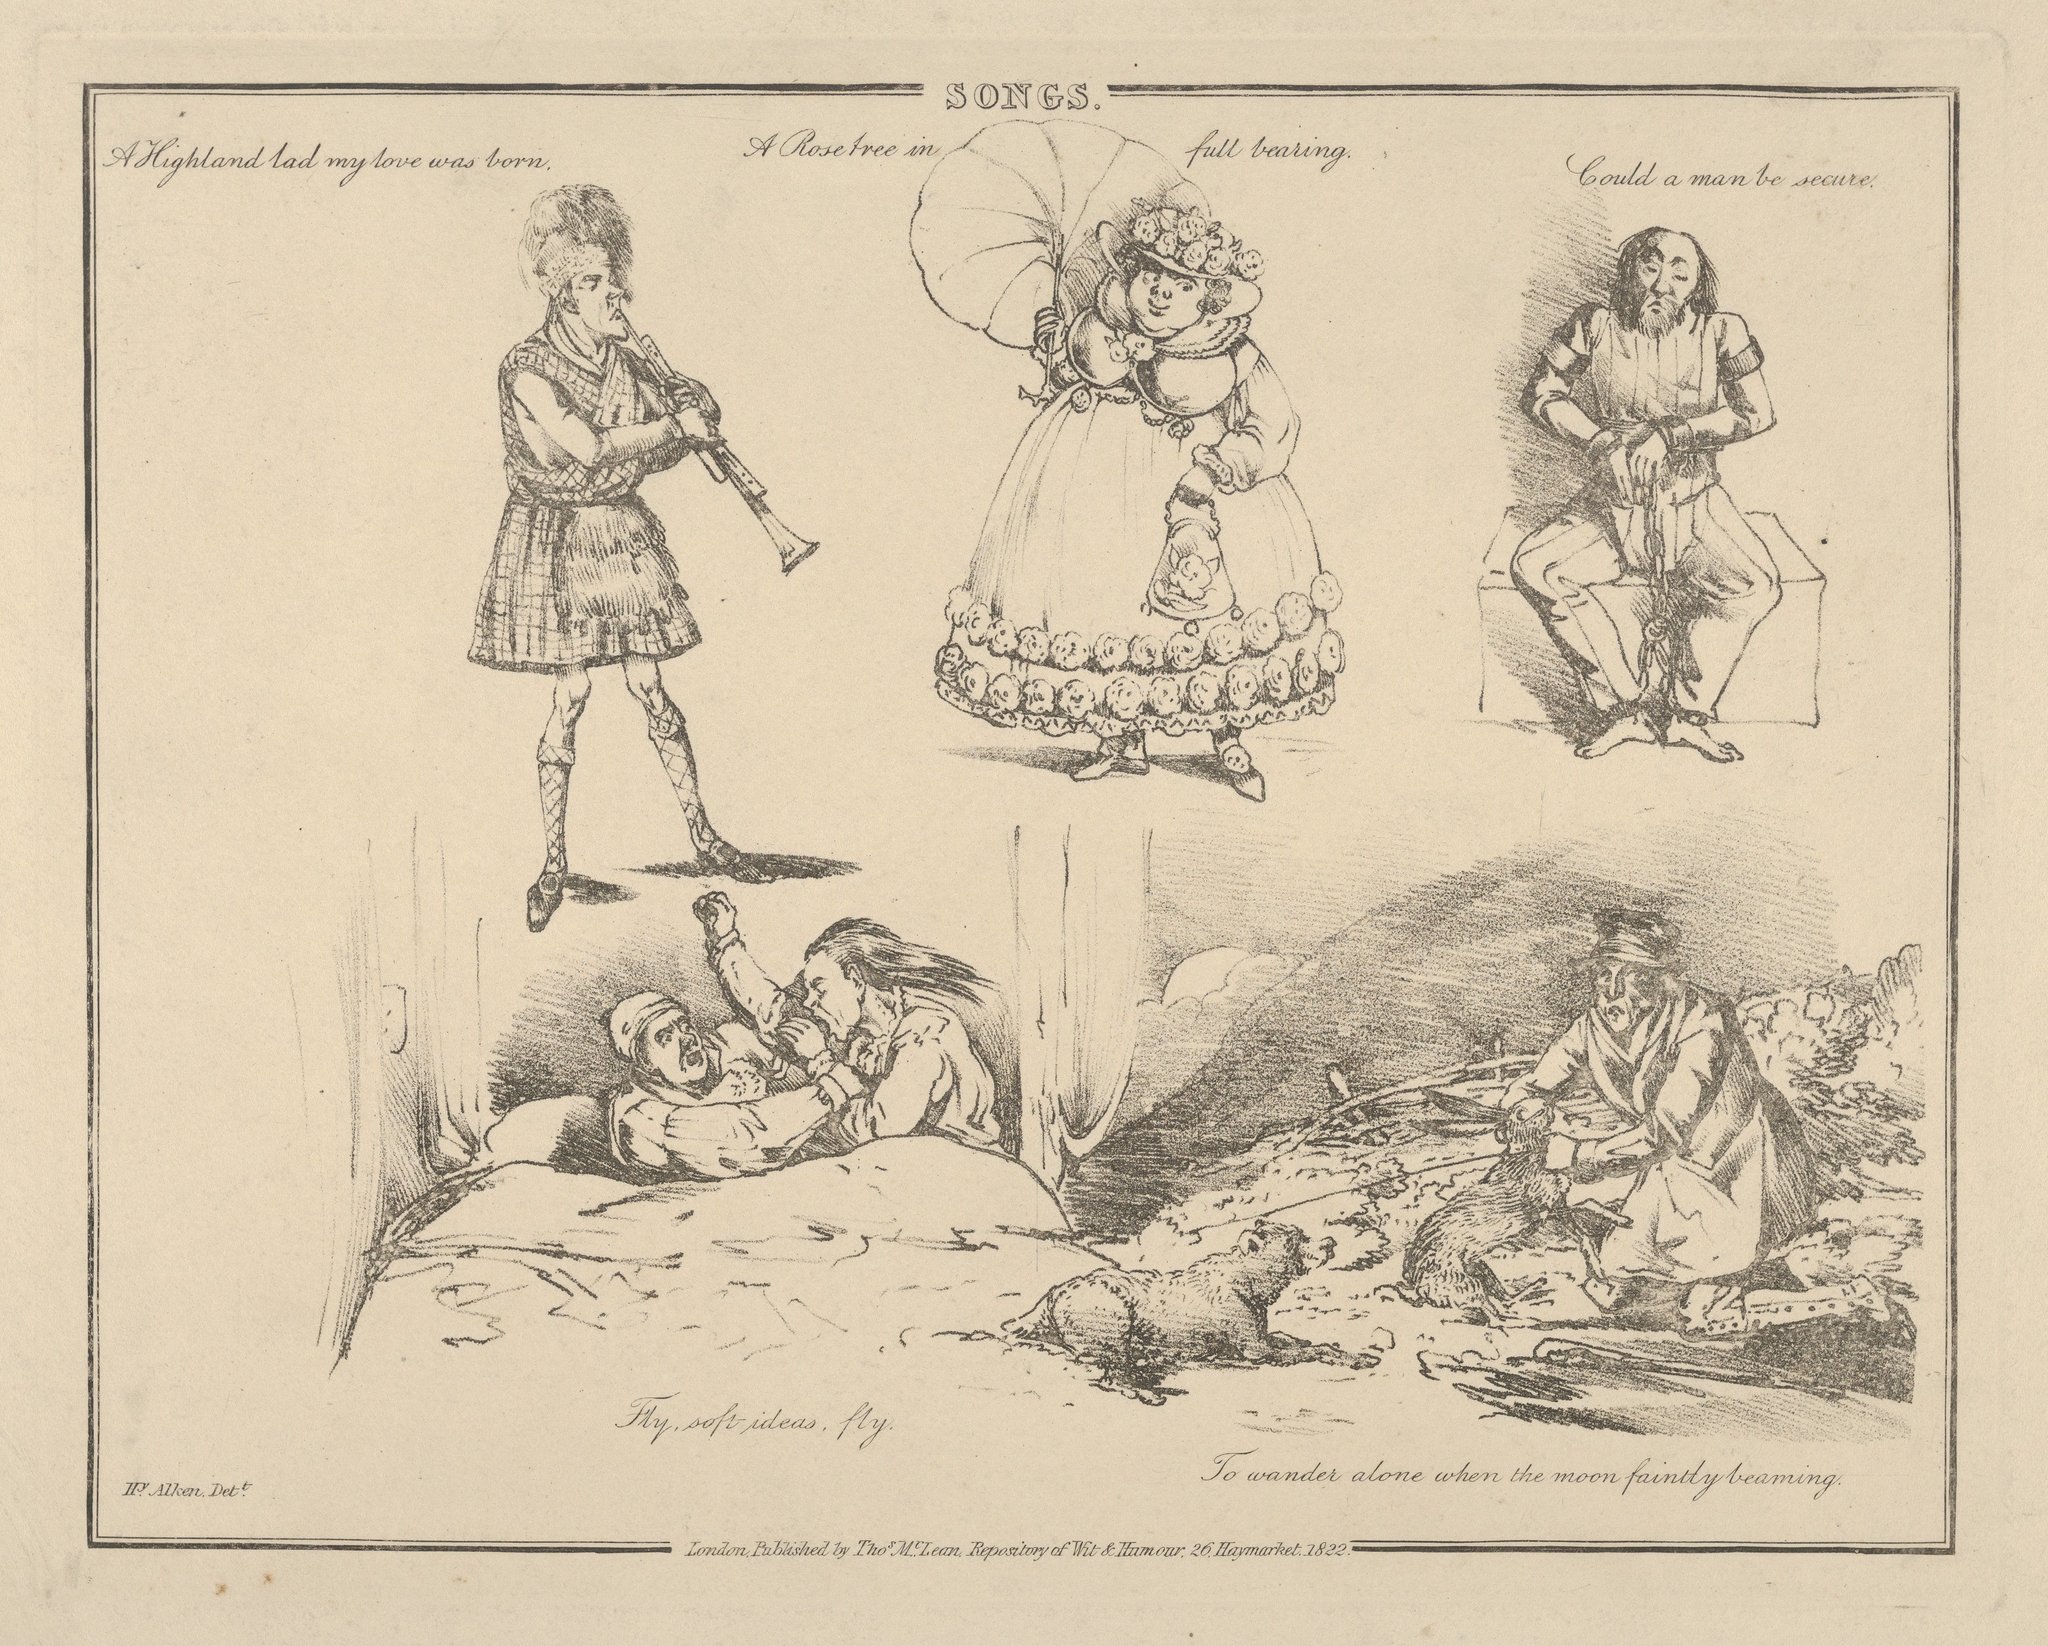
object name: print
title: Songs: "A Highland lad my love was born..."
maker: henry alken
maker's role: artist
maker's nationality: british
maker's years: 1785-1851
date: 1822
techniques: etching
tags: musical instruments,animals,satire,men,women